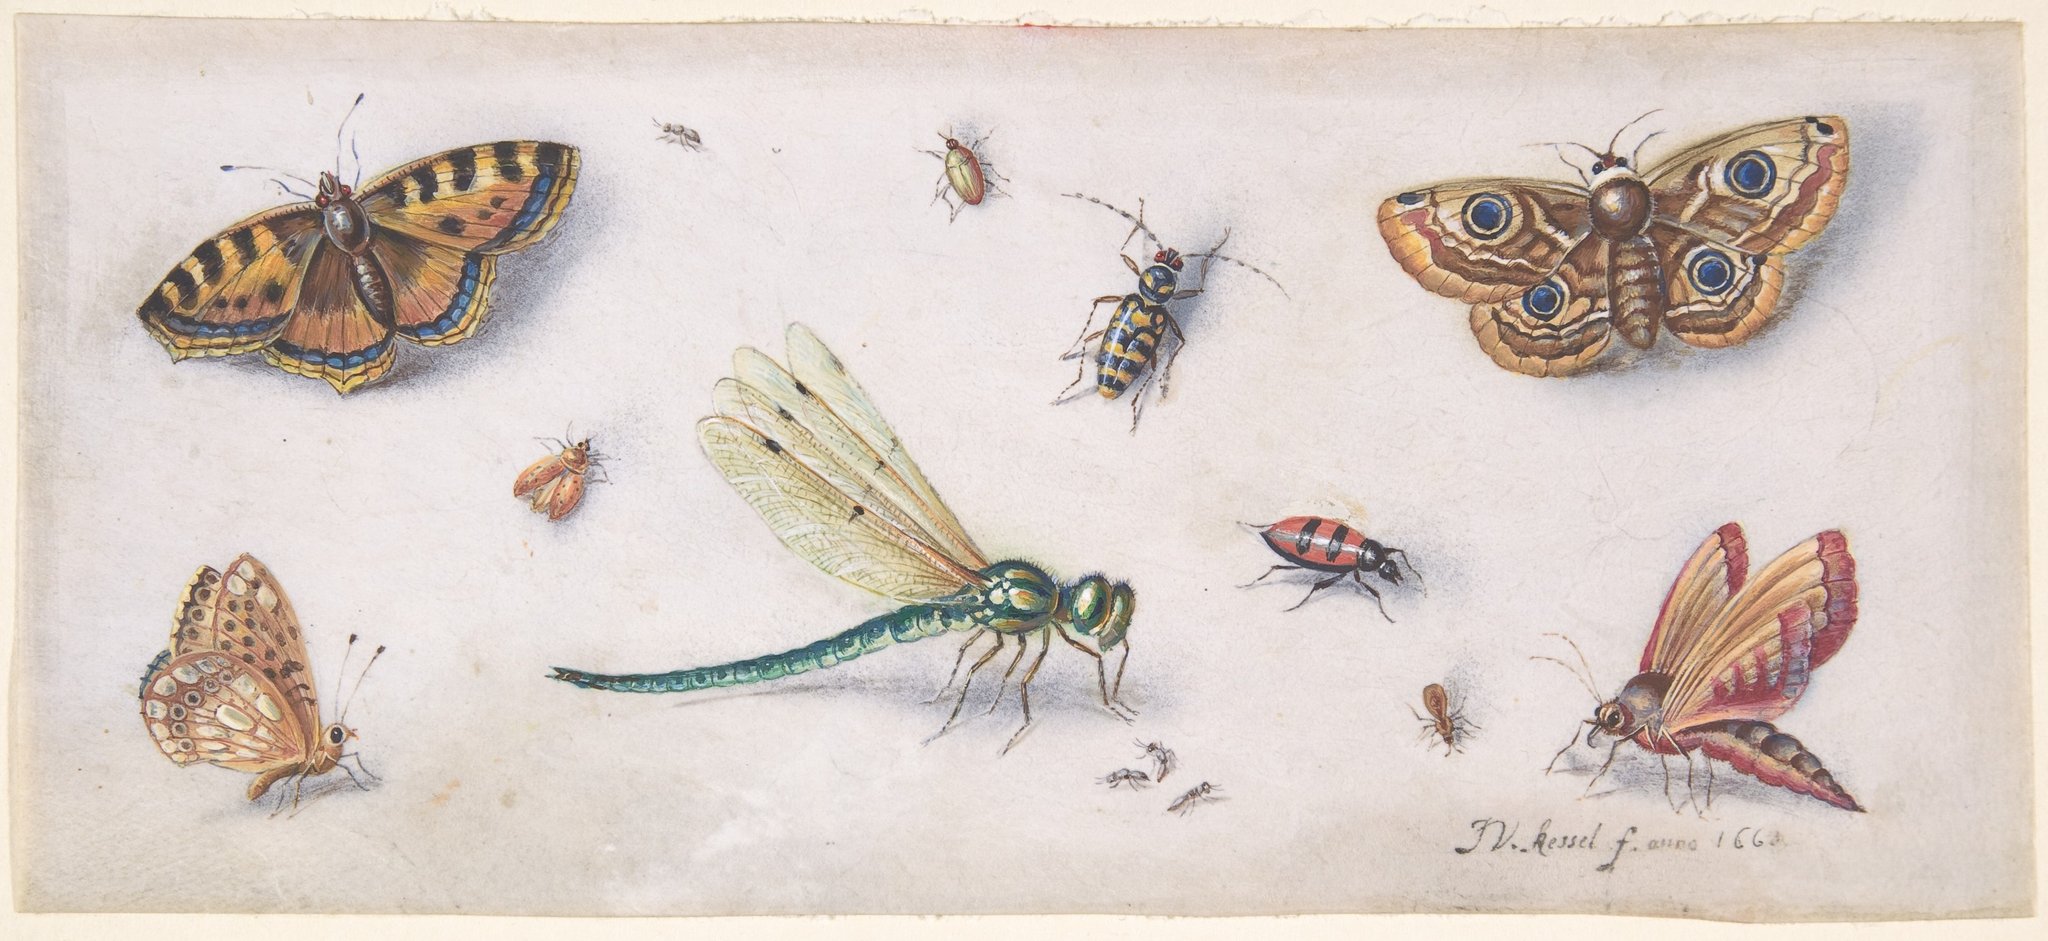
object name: drawing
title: Insects, Butterflies, and a Dragonfly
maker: jan van kessel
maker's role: artist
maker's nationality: flemish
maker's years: 1626-1679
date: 1662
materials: chalk, gouache, parchment, watercolor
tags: insects,butterflies,dragonflies